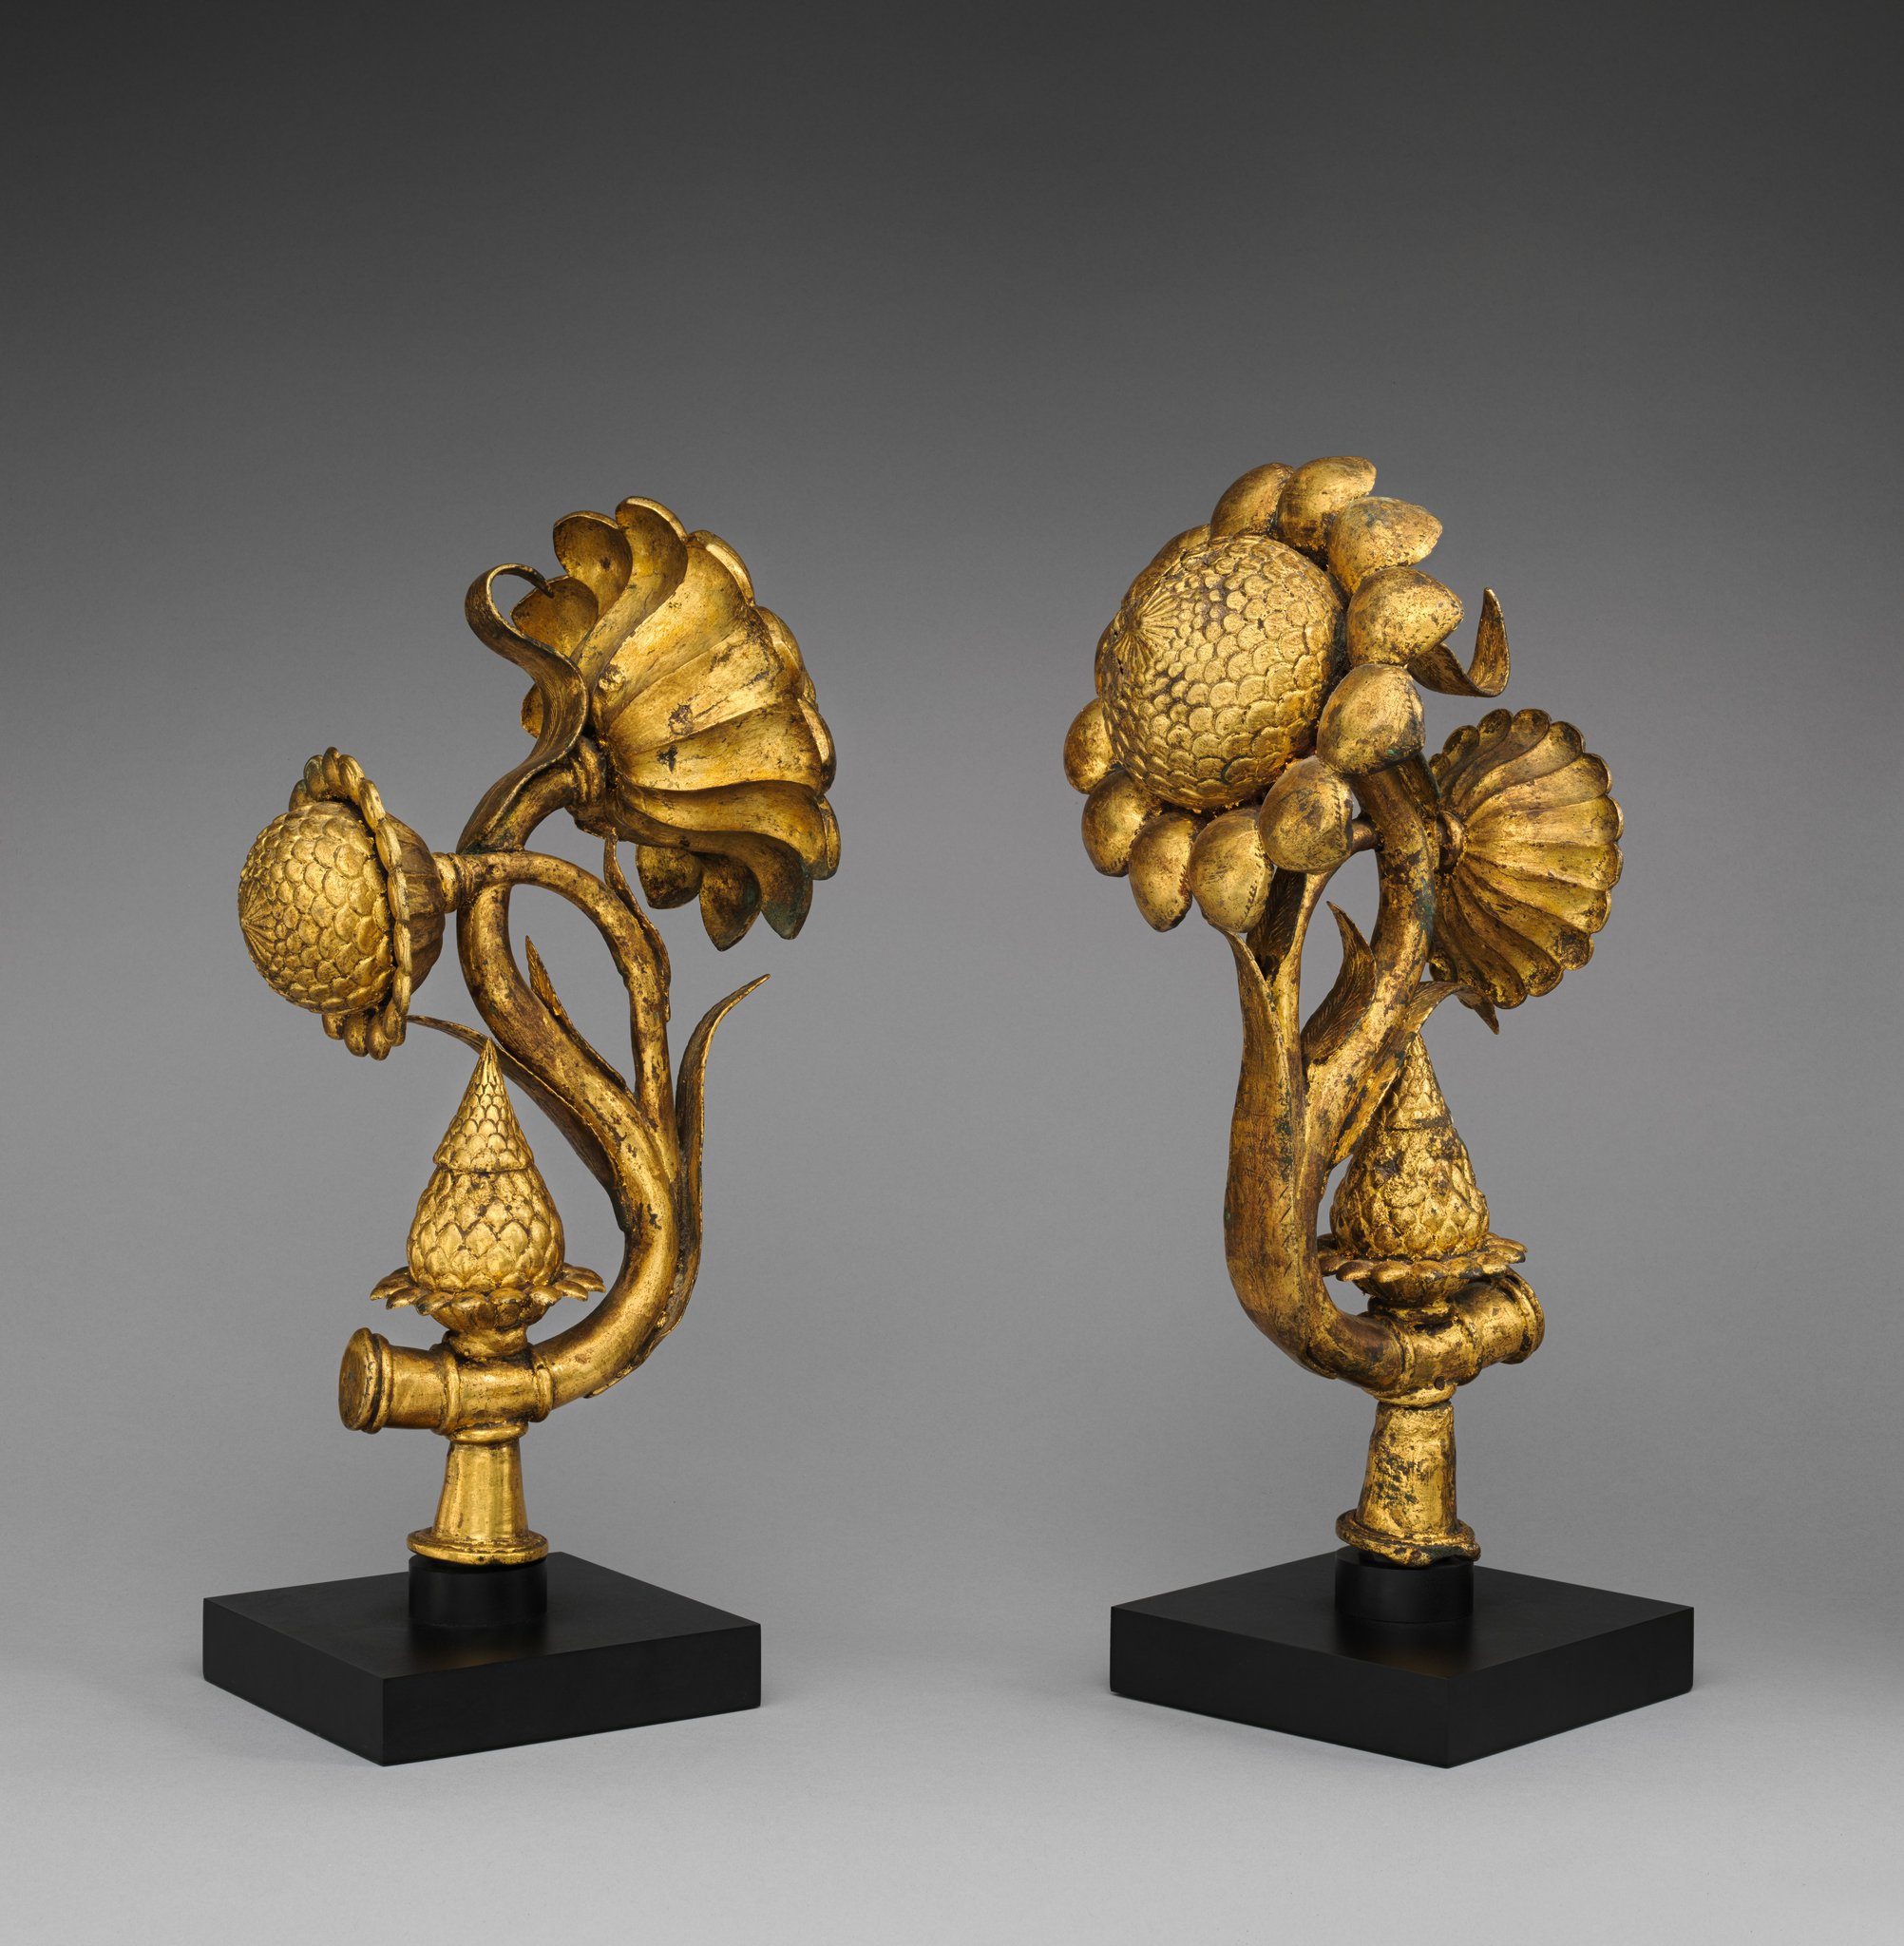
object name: finial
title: A Pair of Lotus Finials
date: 1650-1680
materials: copper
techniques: casting, chasing, gilding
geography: india